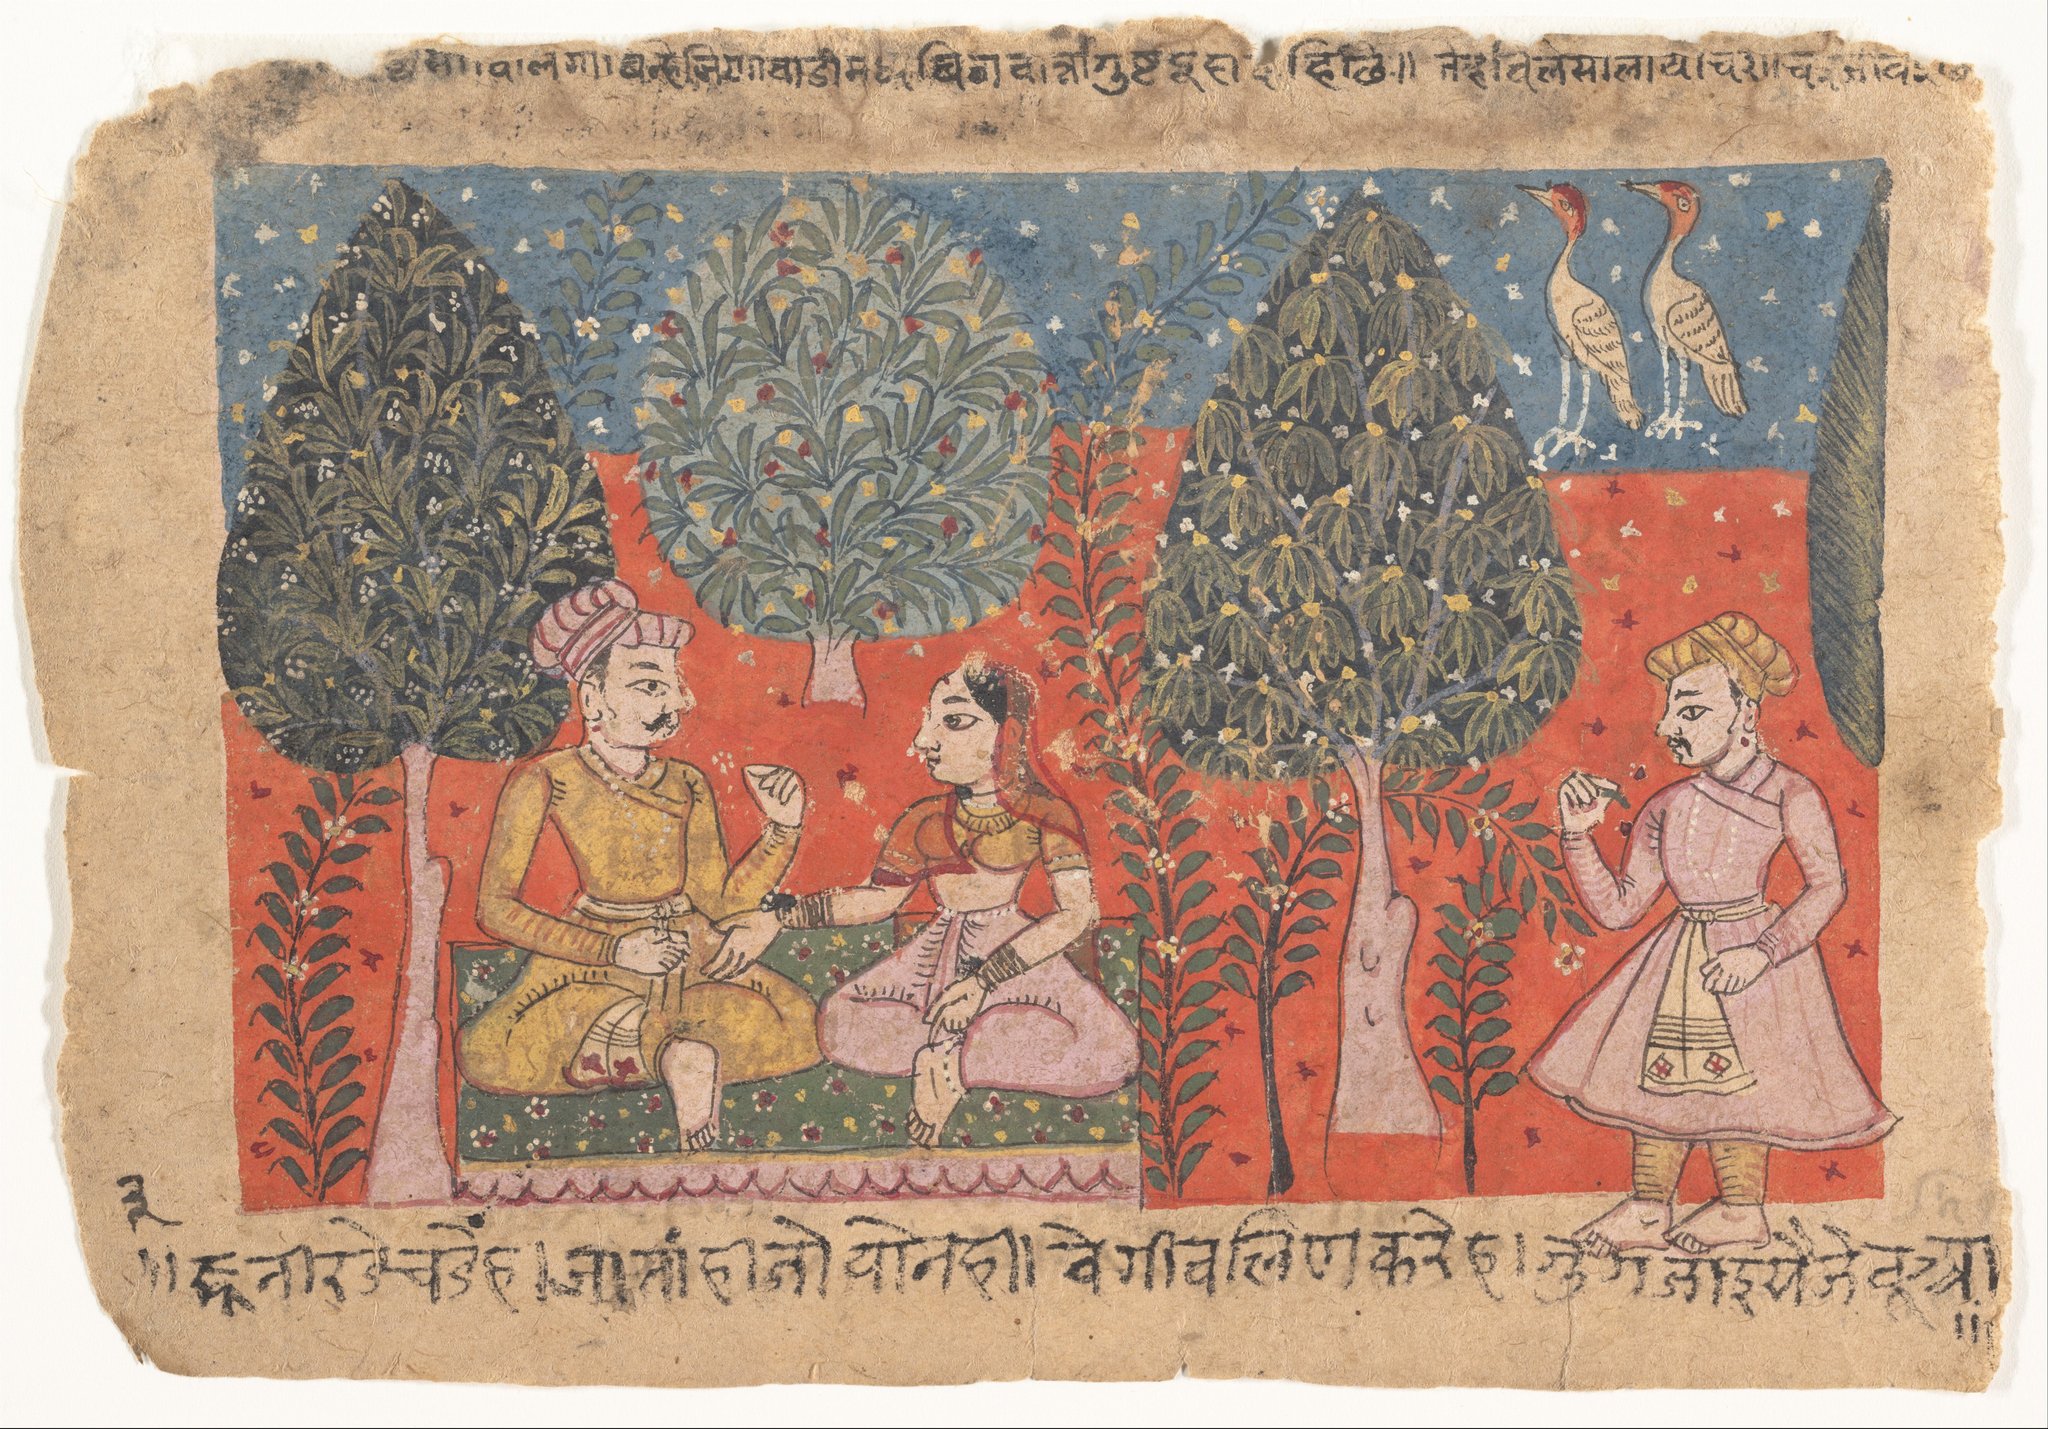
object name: folio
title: Page from a Dispersed Rasikapriya (Lover's Breviary)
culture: indian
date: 1650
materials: ink, paper, watercolor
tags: birds,men,women,trees